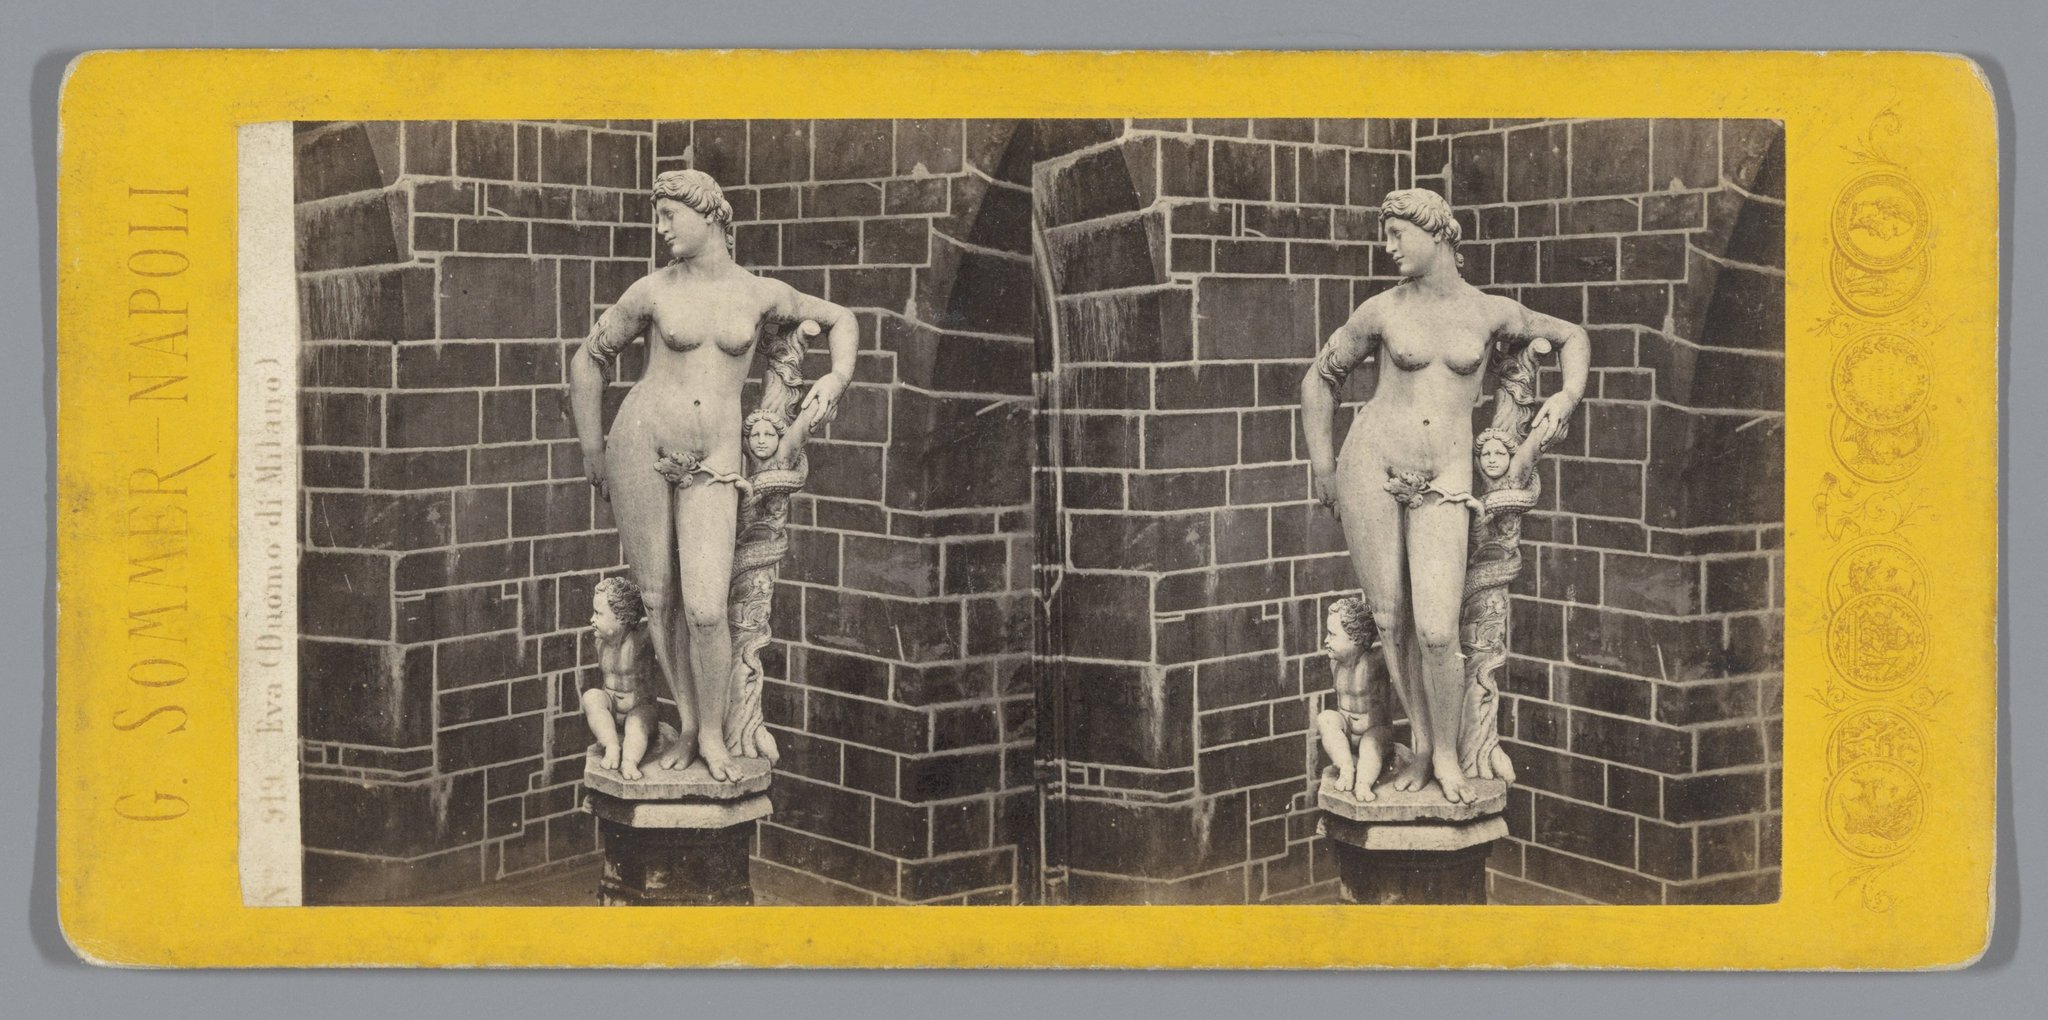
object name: stereograph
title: Eva (Duomo di Milano)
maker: giorgio sommer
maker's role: fotograaf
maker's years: 1834-1914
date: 1860-1880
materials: cardboard, photographic support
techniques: albumen print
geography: milan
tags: eve (not in biblical context), piece of sculpture, reproduction of a piece of sculpture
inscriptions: inscription: ‘Milaan : Dom : Eva’, number: ‘No. 919’